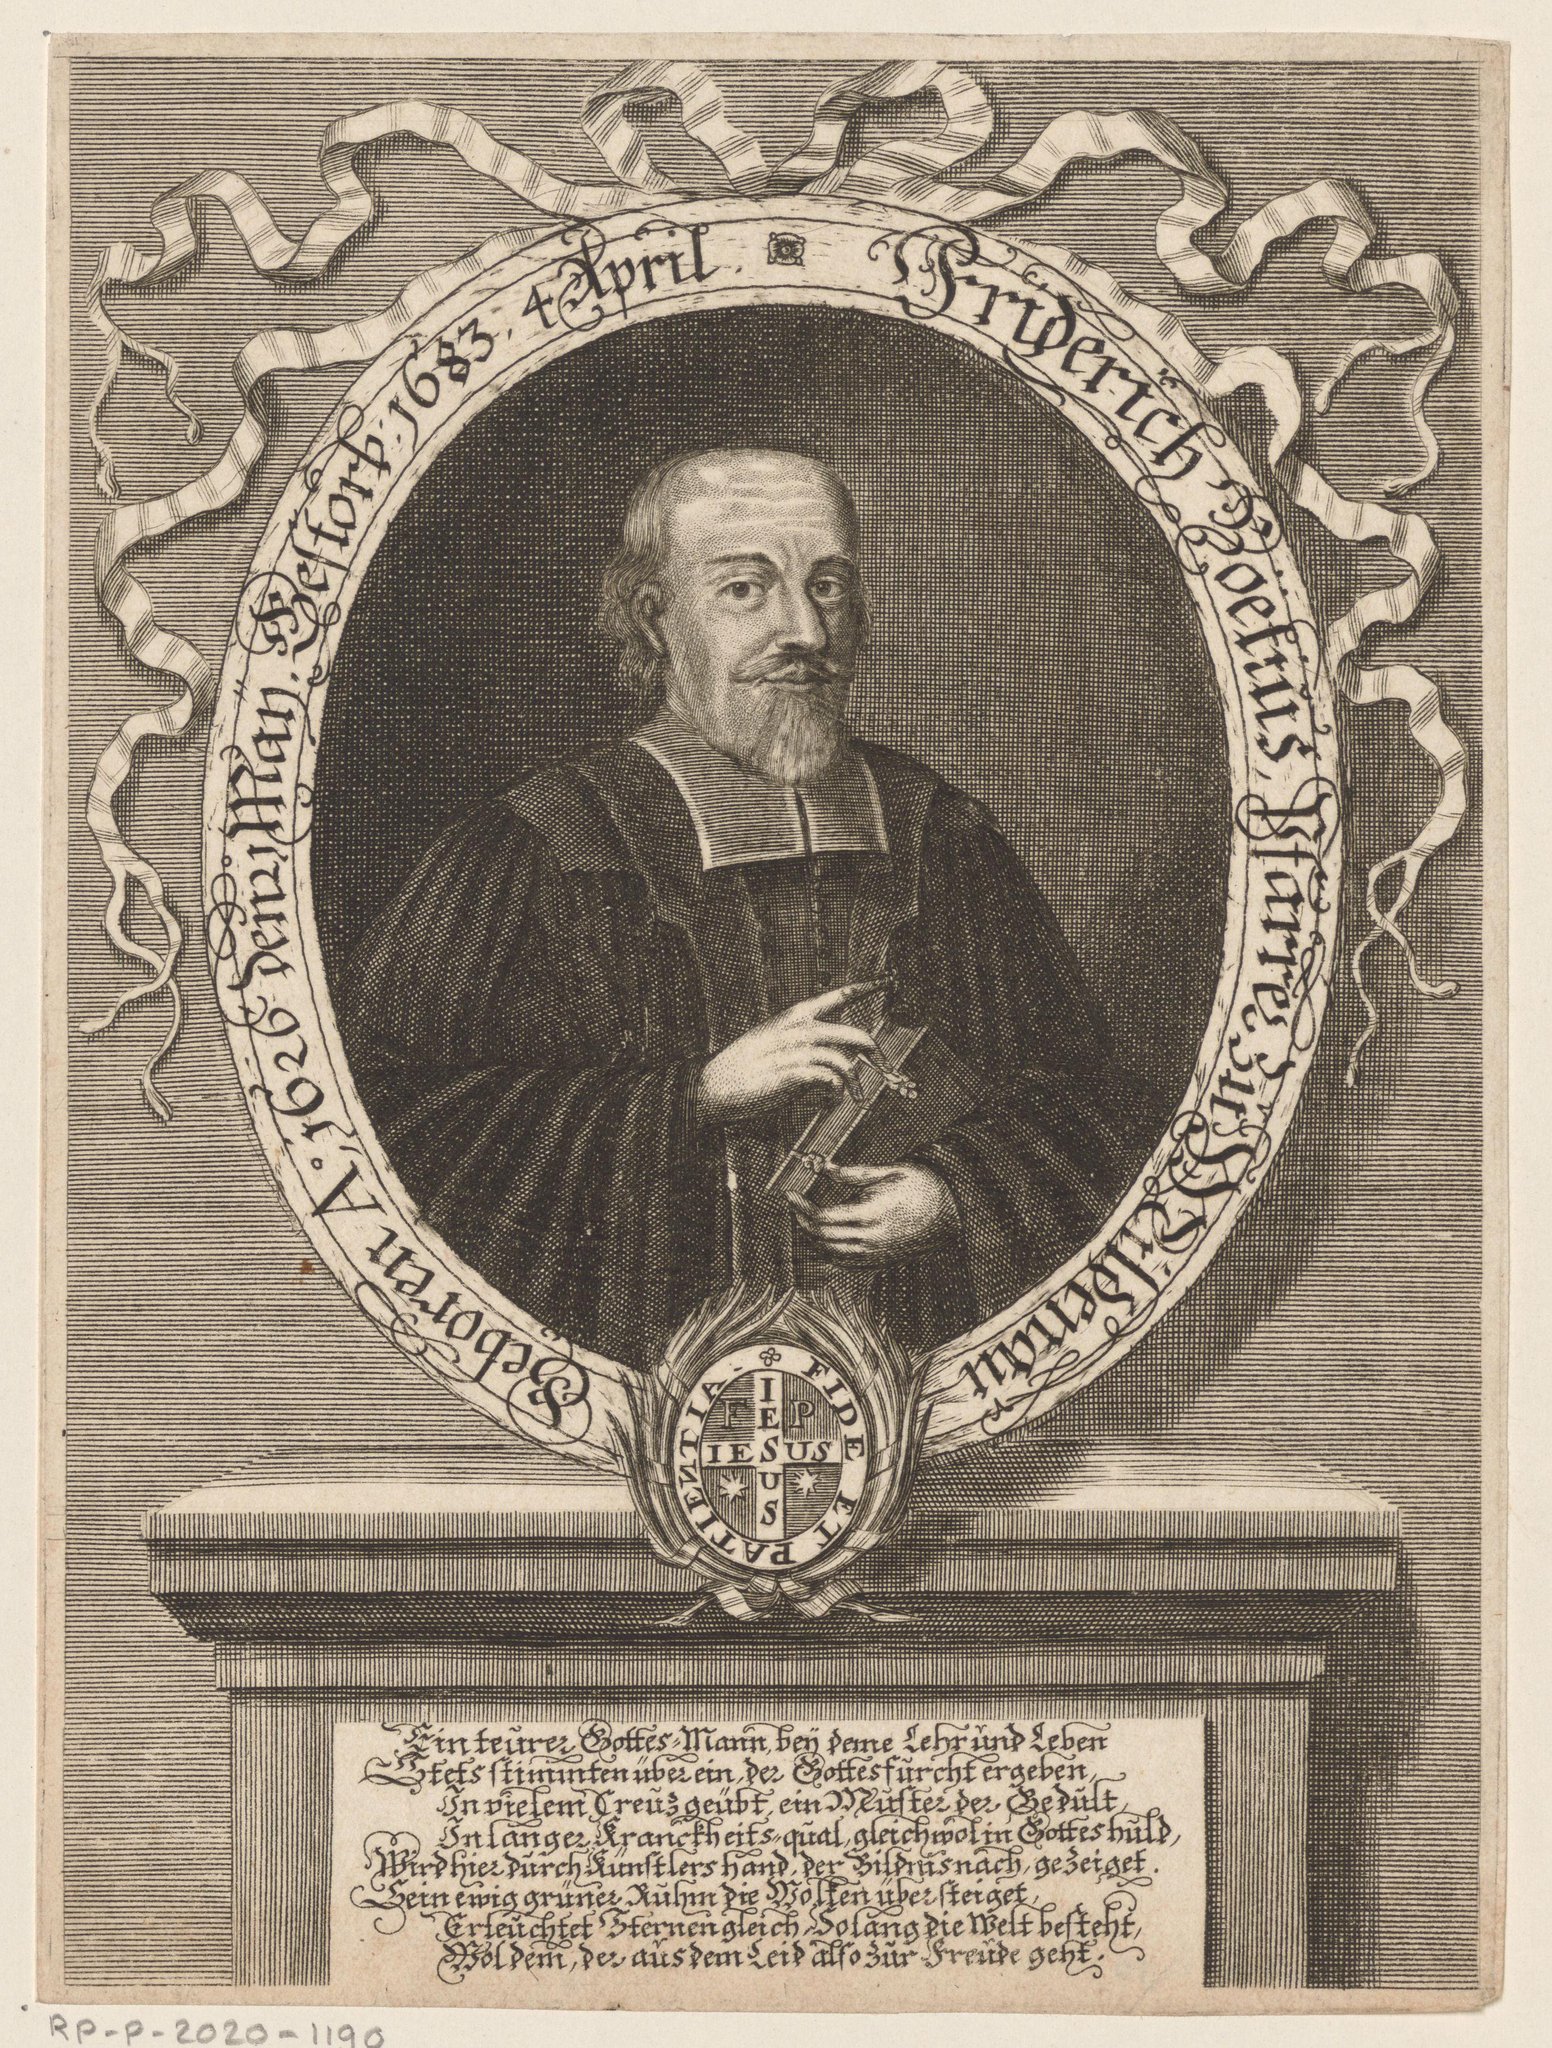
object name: print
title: Friderich Böetius, Pfarrer (...)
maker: Anonymous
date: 1683-1699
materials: paper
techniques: engraving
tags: historical persons, priests ~ hierarchy of priests